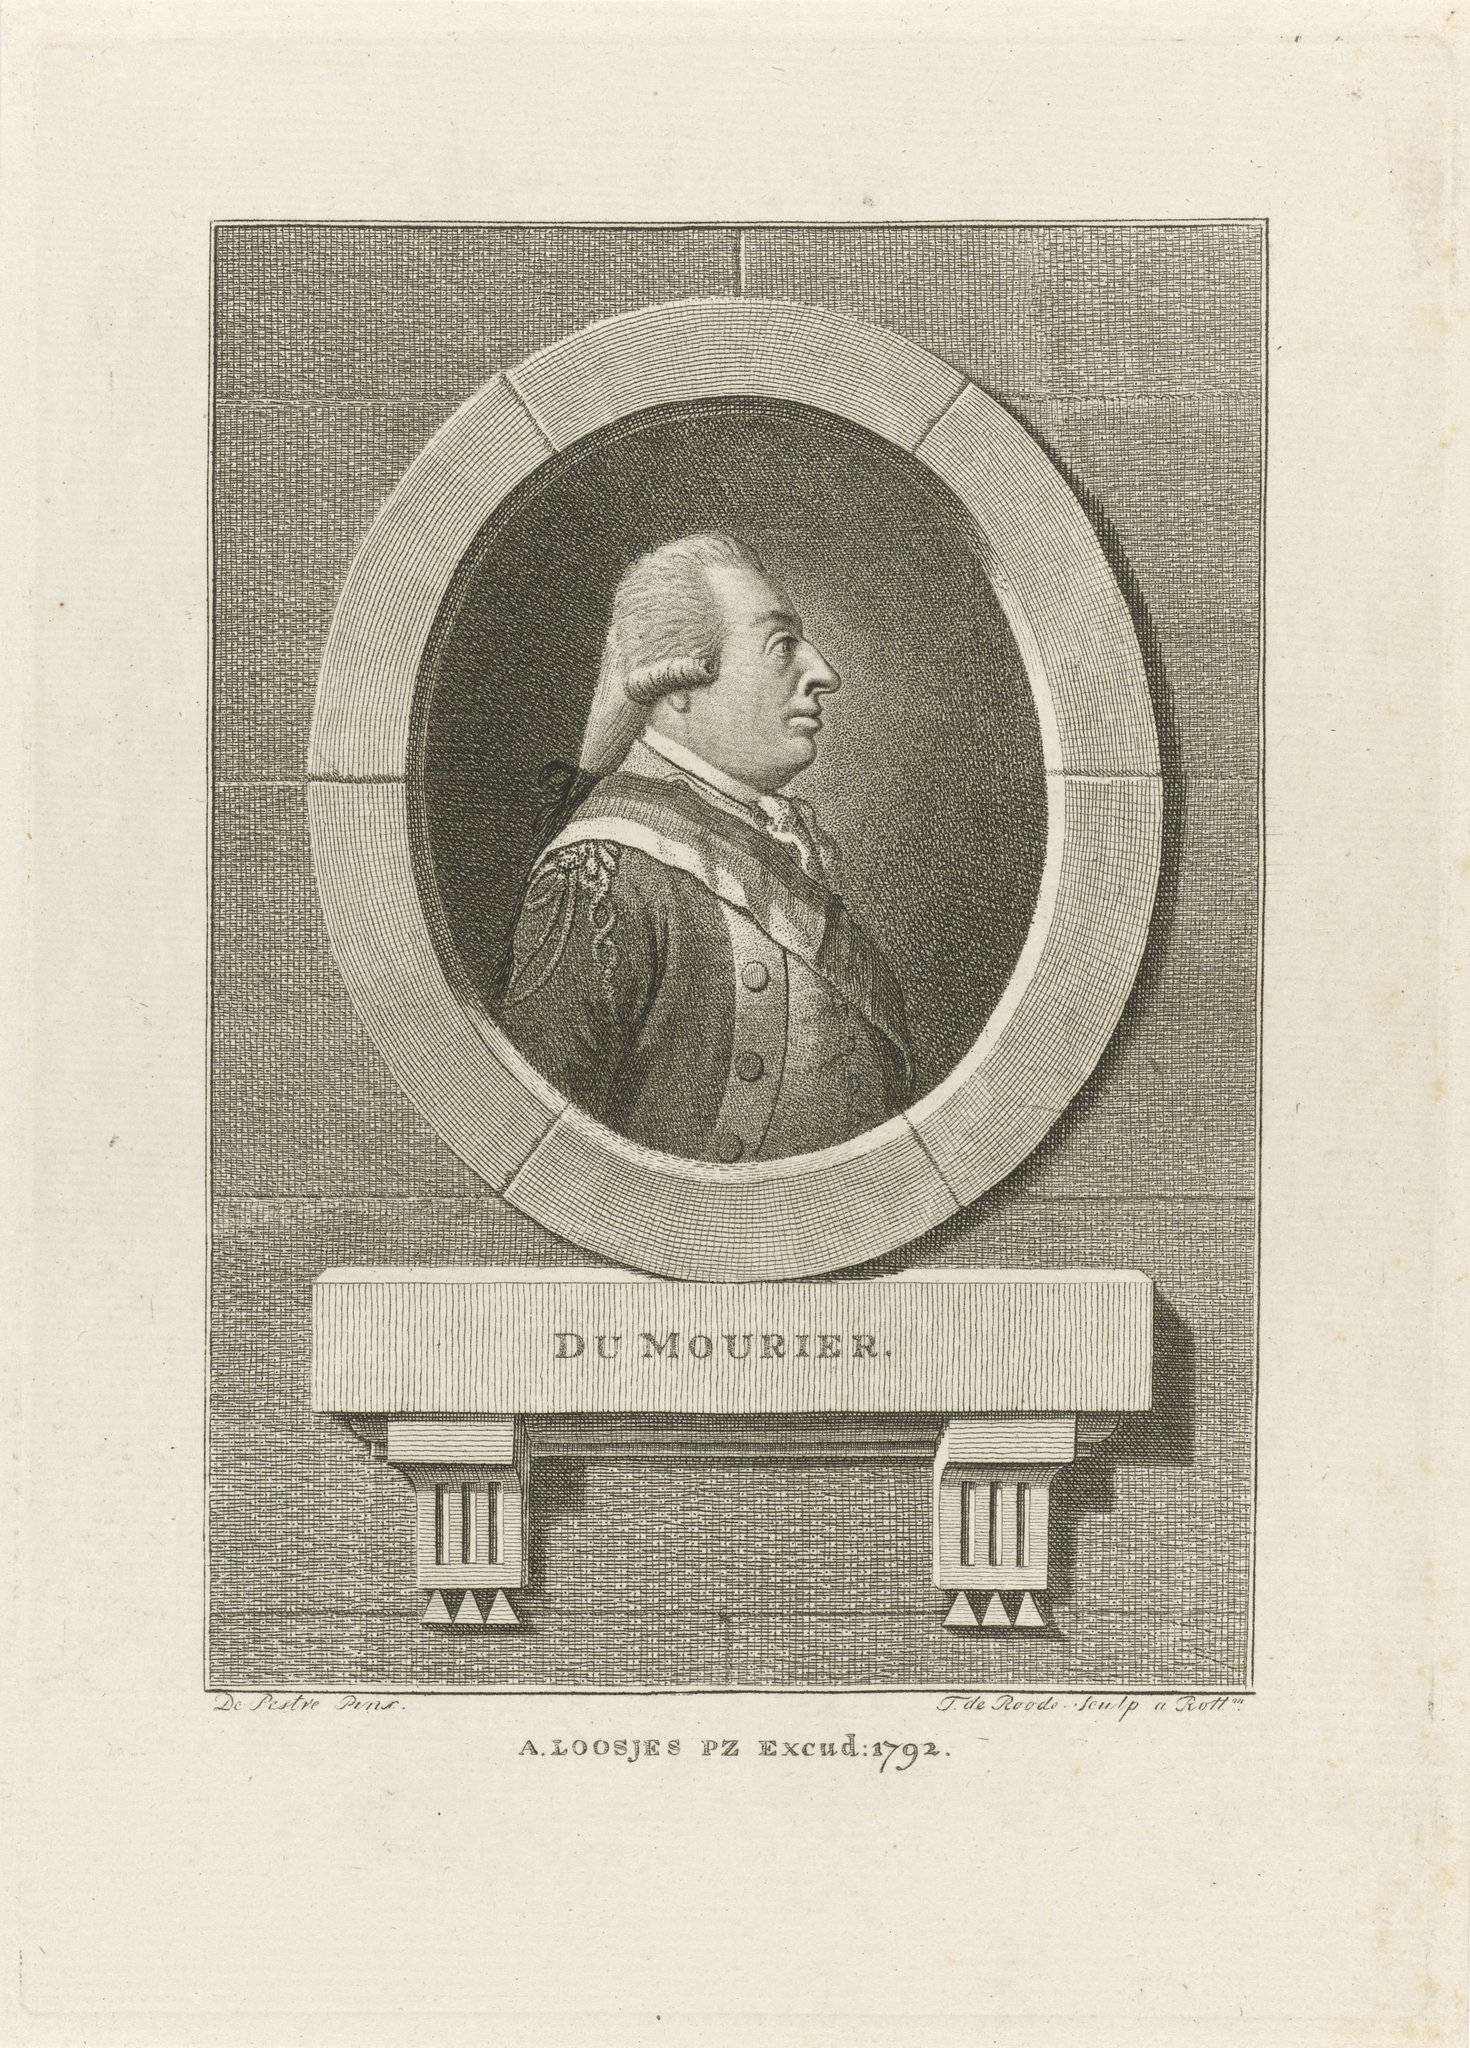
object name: print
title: Portret van Charles François Dumouriez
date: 1792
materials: paper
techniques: etching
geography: haarlem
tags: cambrai, turville, generaal, minister, staatsman, diplomaat, charles françois dumouriez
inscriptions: collector's mark: Lugt 2228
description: Portret van de Franse generaal Charles-François du Périer, markies Dumouriez. Op de plint zijn naam.